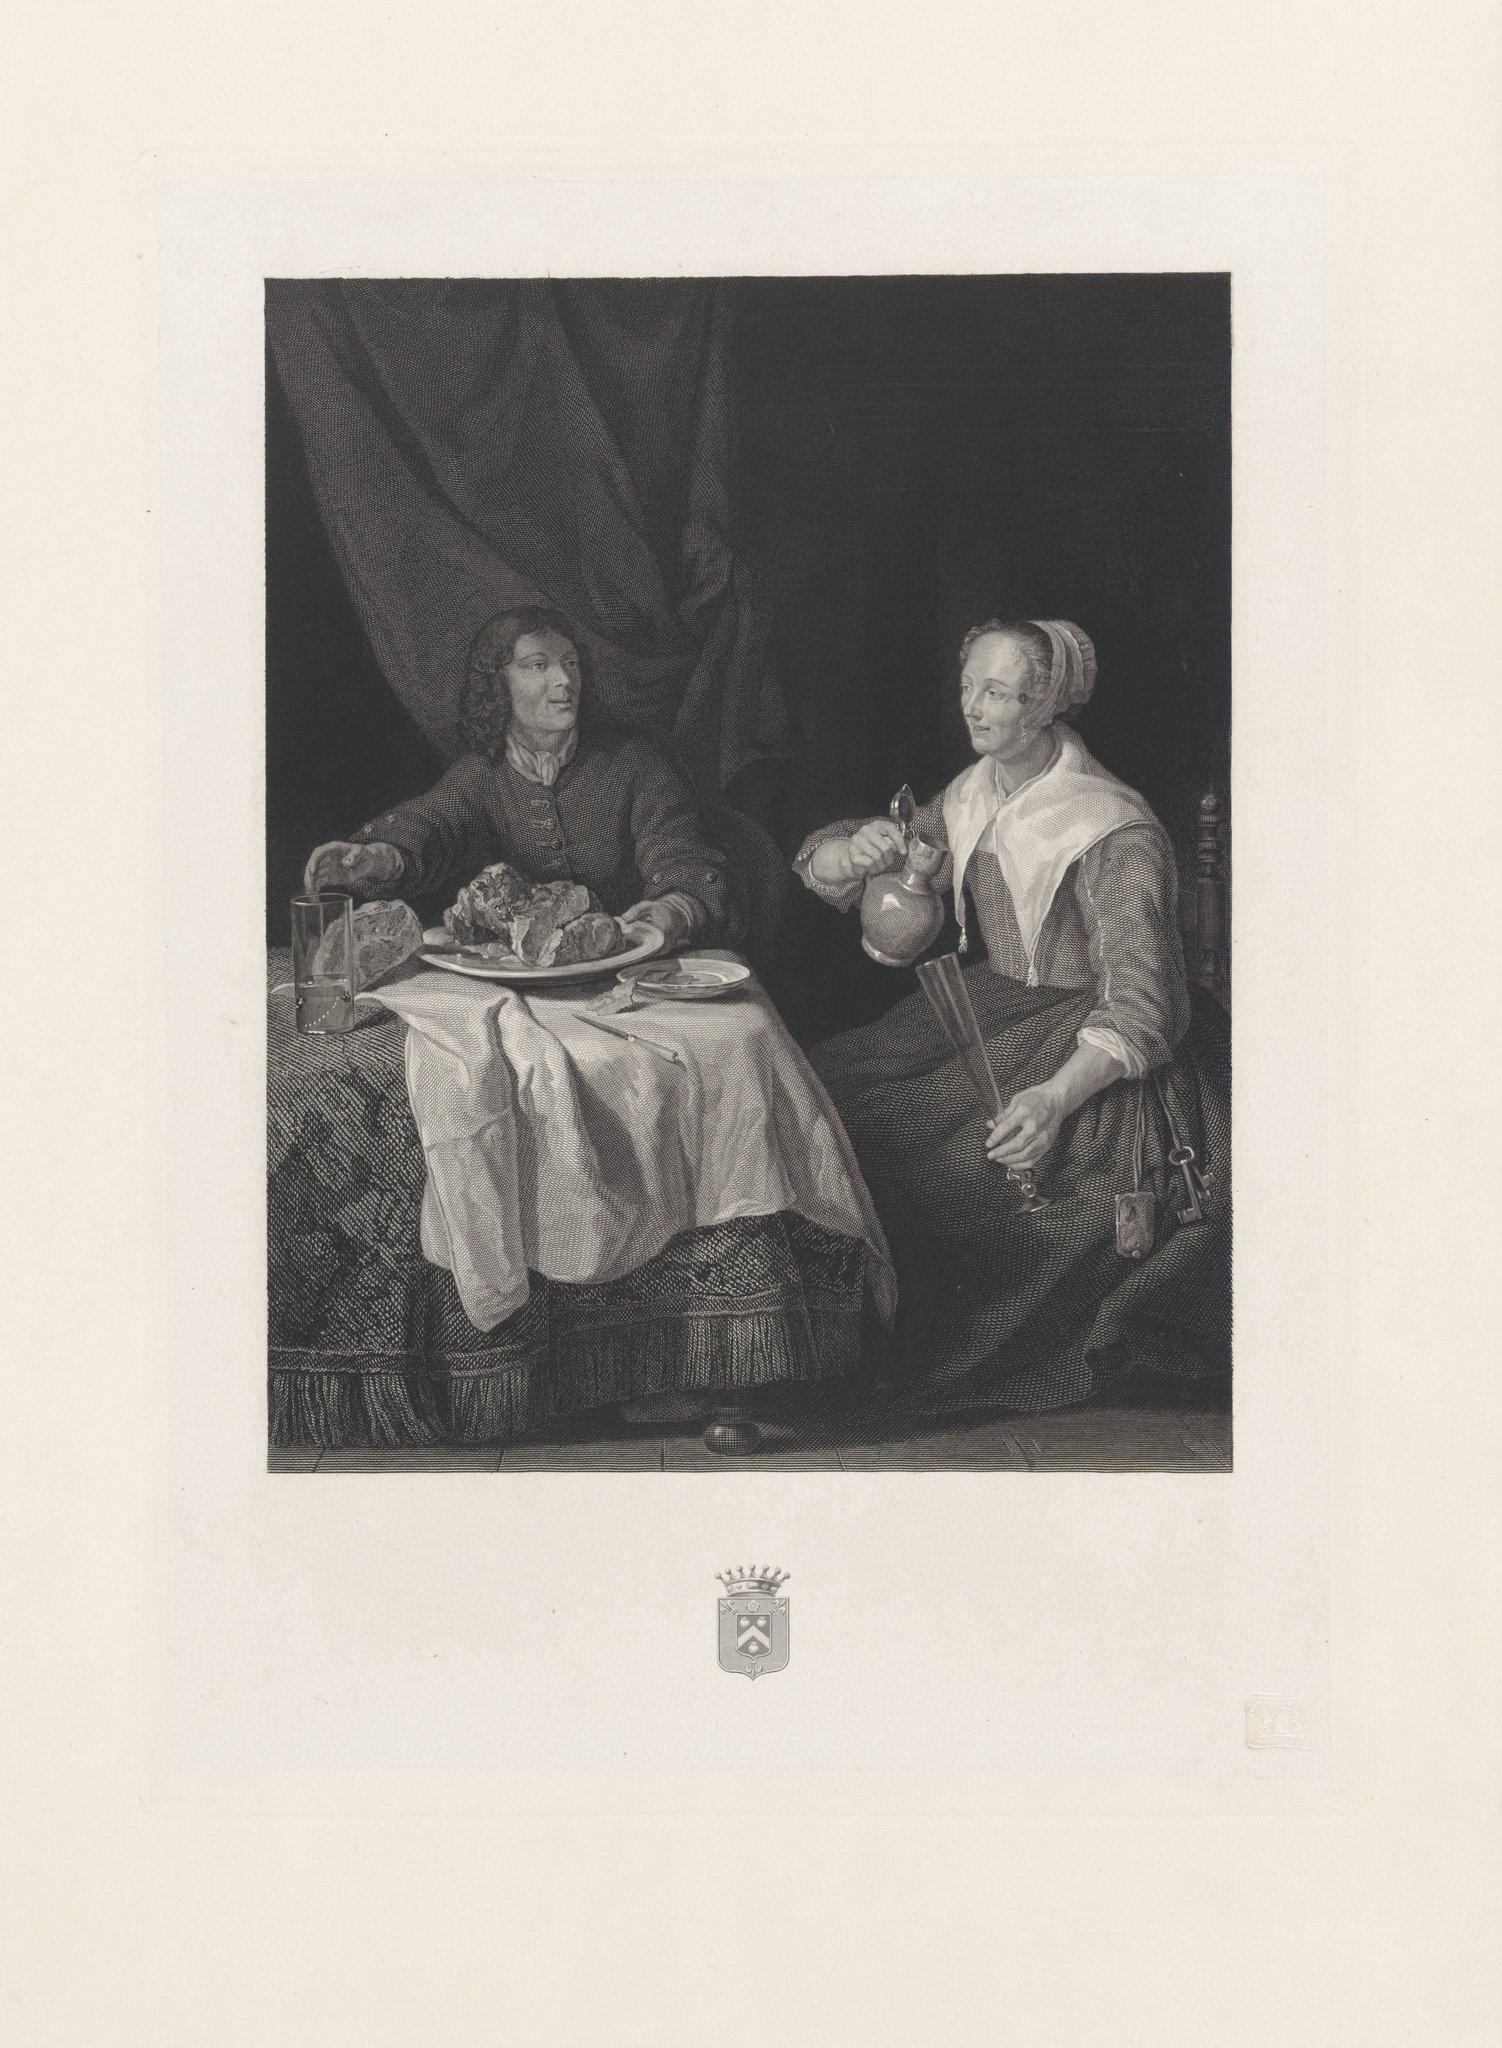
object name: print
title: Man en vrouw aan de maaltijd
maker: dirk jurriaan sluyter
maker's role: draughtsman, print maker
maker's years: 1811-1886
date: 1826-1886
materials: paper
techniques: engraving, etching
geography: amsterdam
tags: middelburg, paris, eating and drinking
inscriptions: collector's mark: Lugt 2228, collector's mark: Lugt 12, check stamp: ‘François Buffa & Fils Fournisseurs du Roi’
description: Een man en een vrouw zitten aan een gedekte tafel. De man grijpt naar een glas, de vrouw staat op het punt zichzelf uit een kruik iets in een hoge glas te schenken. Op tafel staat een bord met een ham, met een homp brood erbij. Onder de prent het wapenschild van Jan Willem, baron Huyssen van Kattendijke.